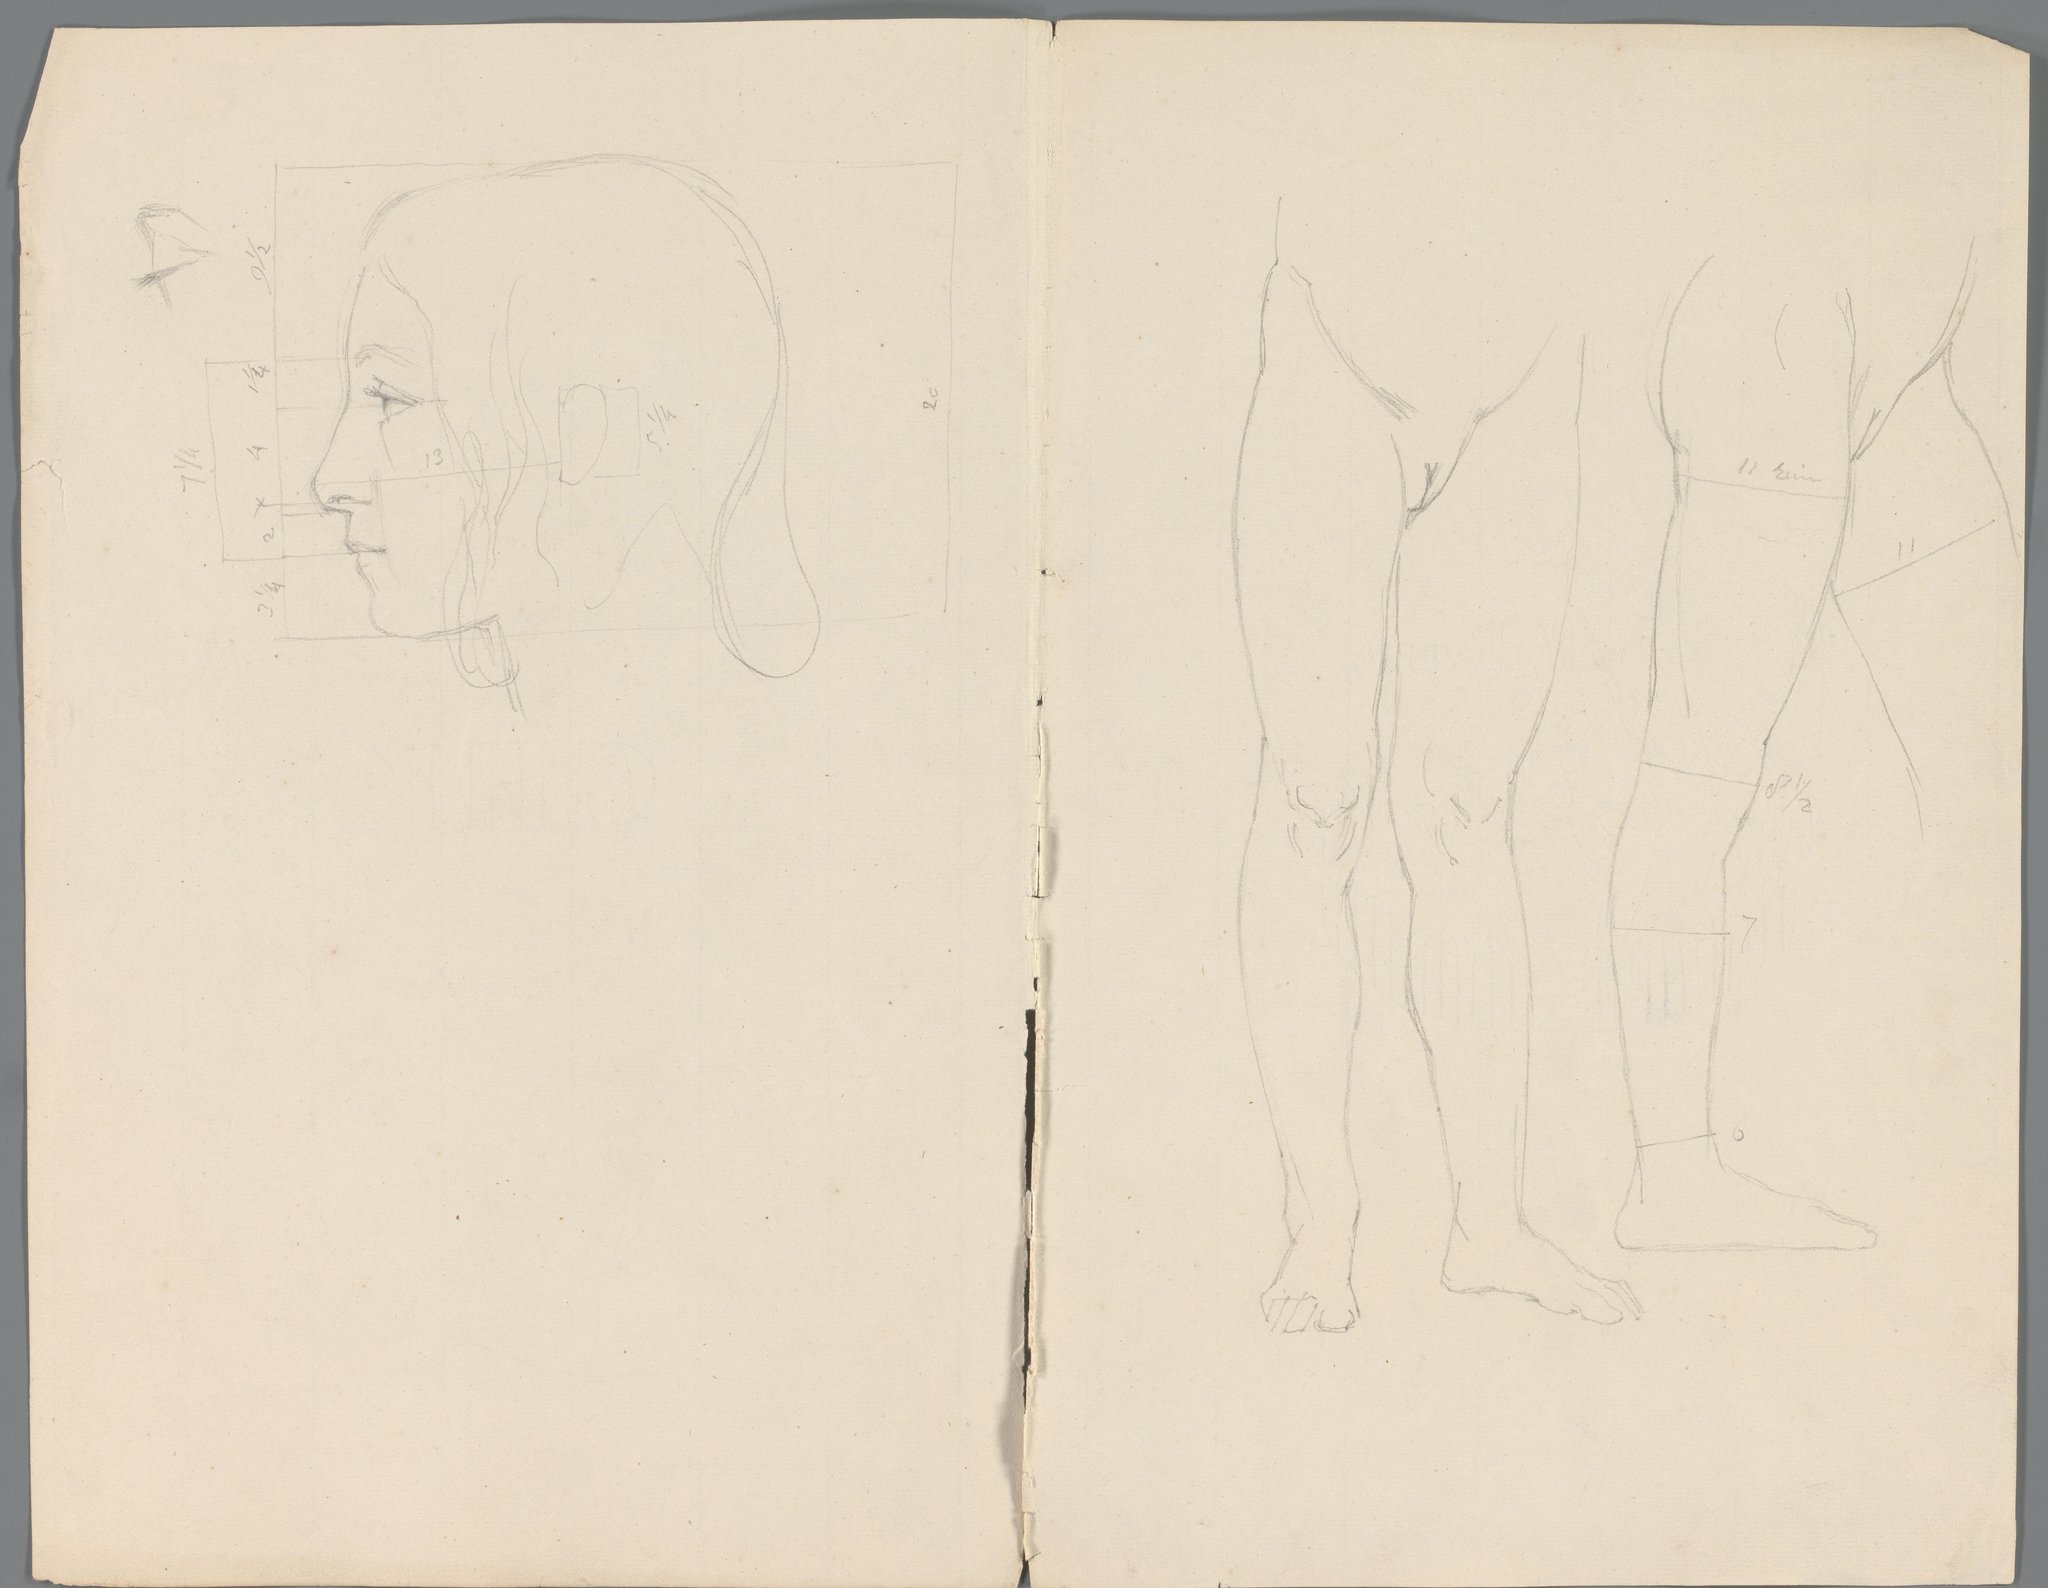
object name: drawing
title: Studie van een gezicht en onderbenen van een vrouw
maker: jacobus everhardus josephus van den berg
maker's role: draughtsman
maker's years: 1802-1861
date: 1812-1861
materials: paper, pencil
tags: face, legs